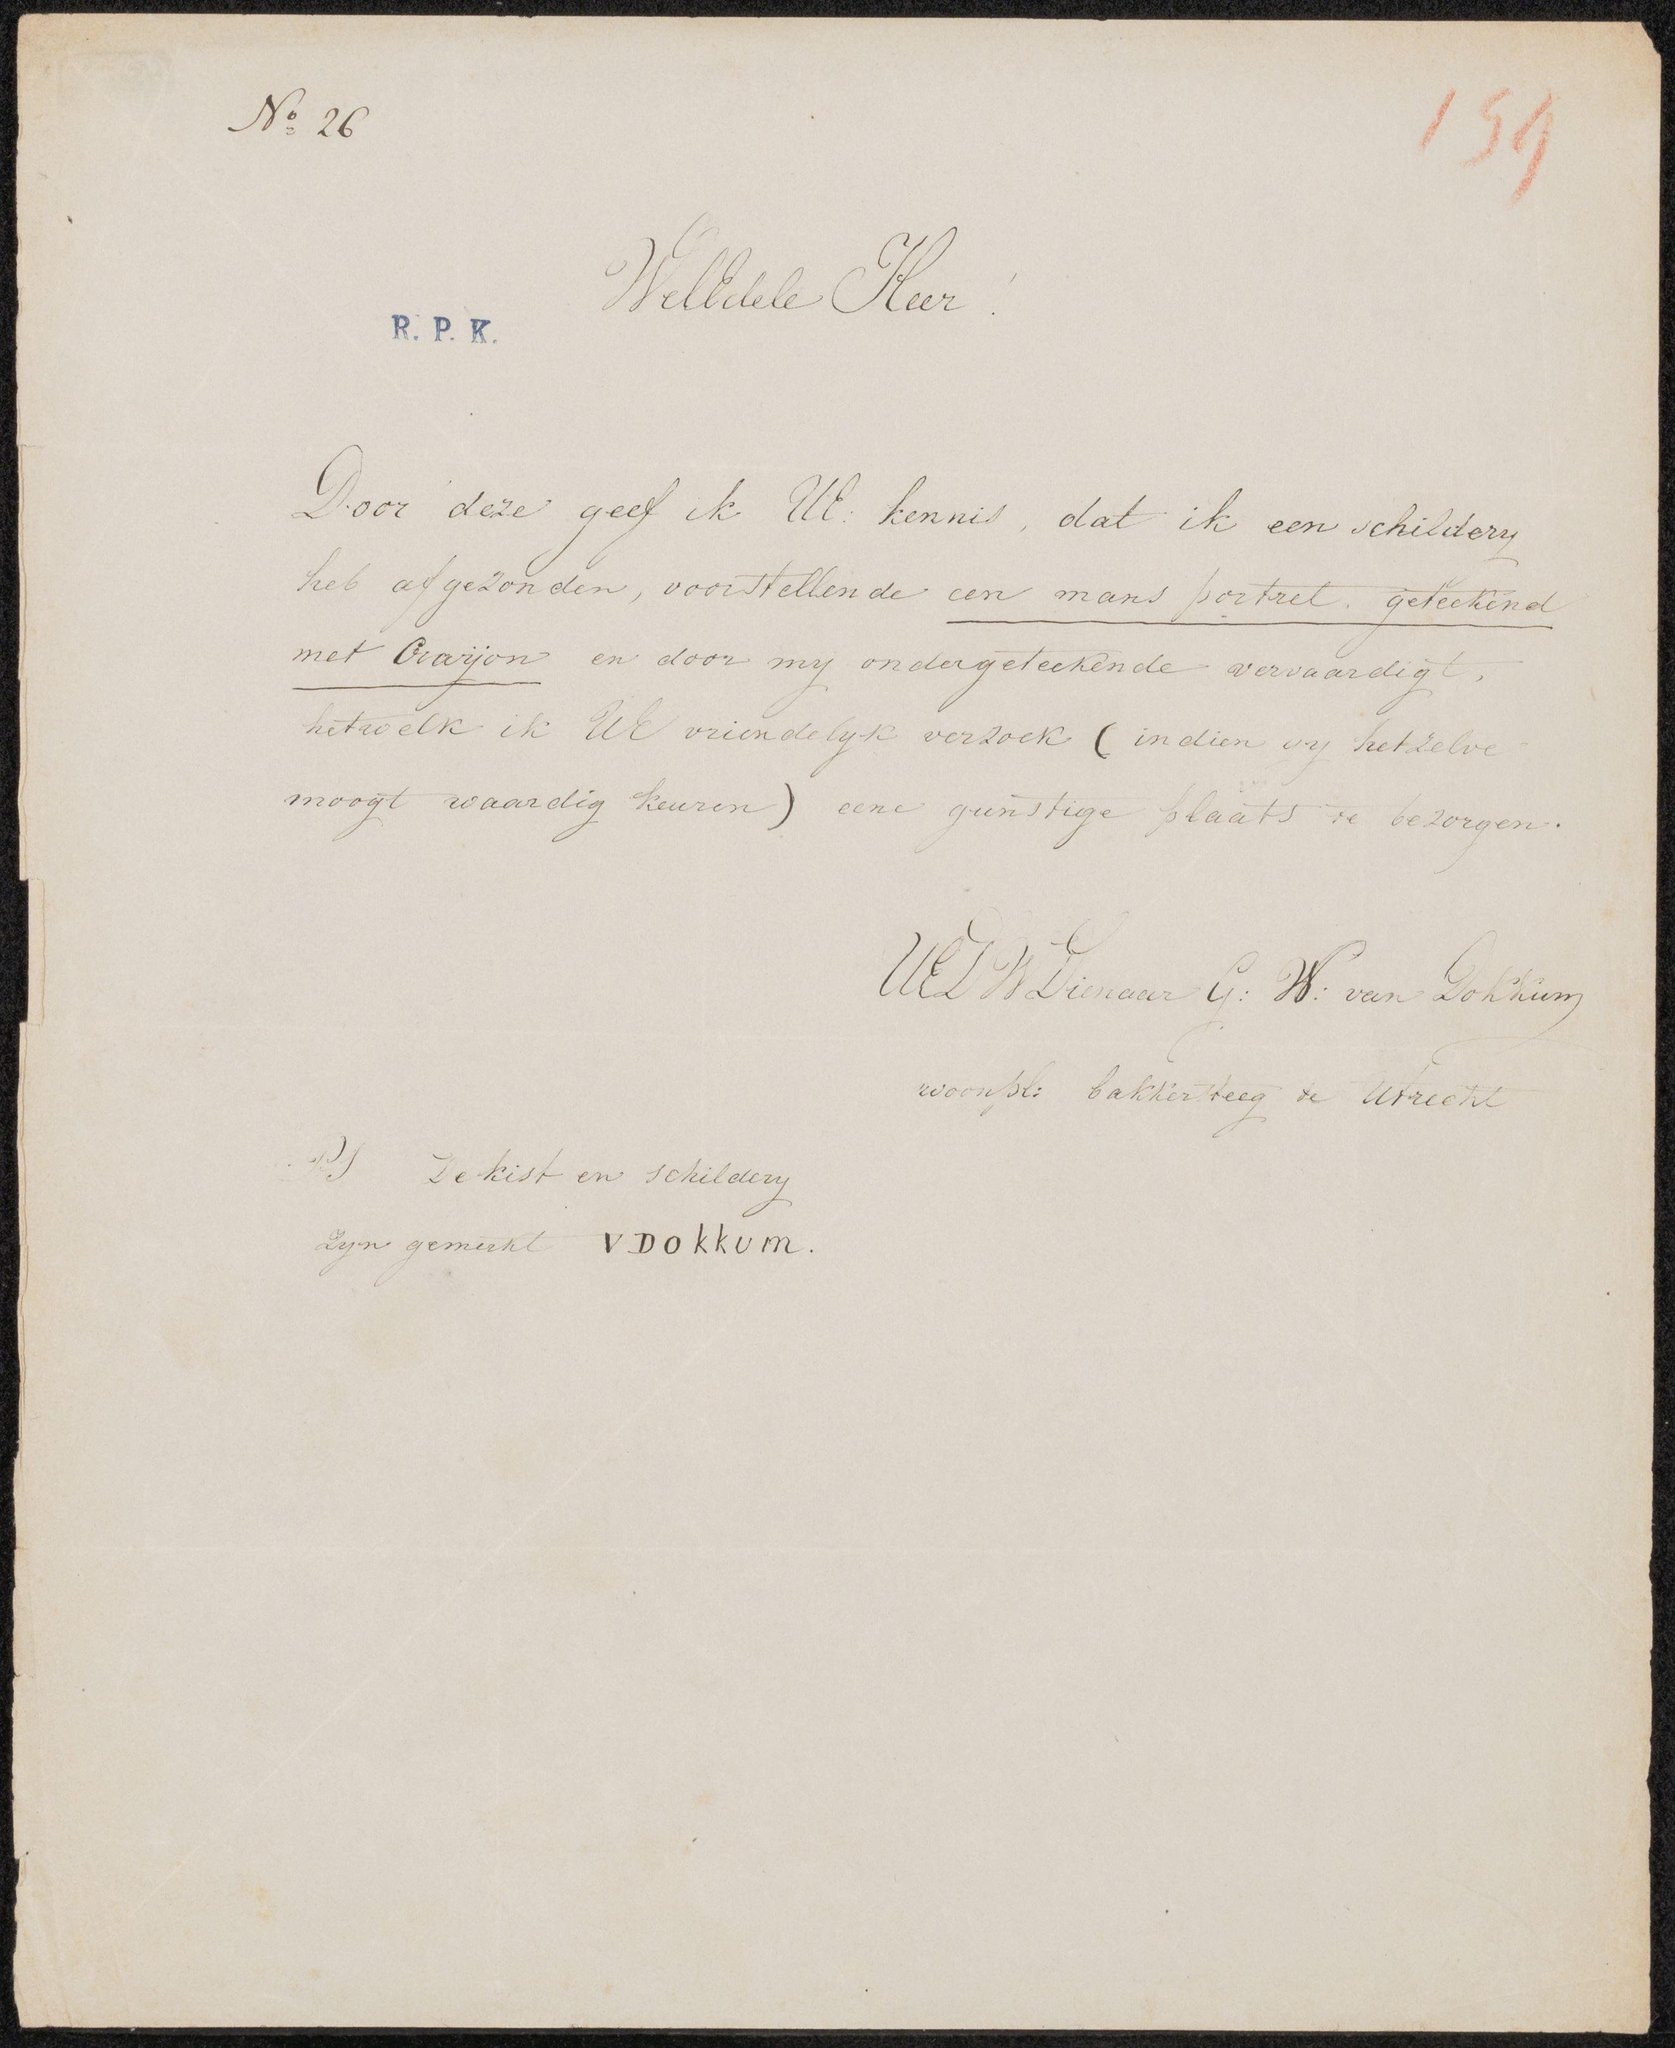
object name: letter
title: Brief aan anoniem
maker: gerardus willem van dokkum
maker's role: designer, print maker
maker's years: 1828-1903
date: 1838-1903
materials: ink, paper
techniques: pen, writing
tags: drawing, anonymous historical person portrayed, exhibition ~ art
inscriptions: collector's mark: Lugt 2233